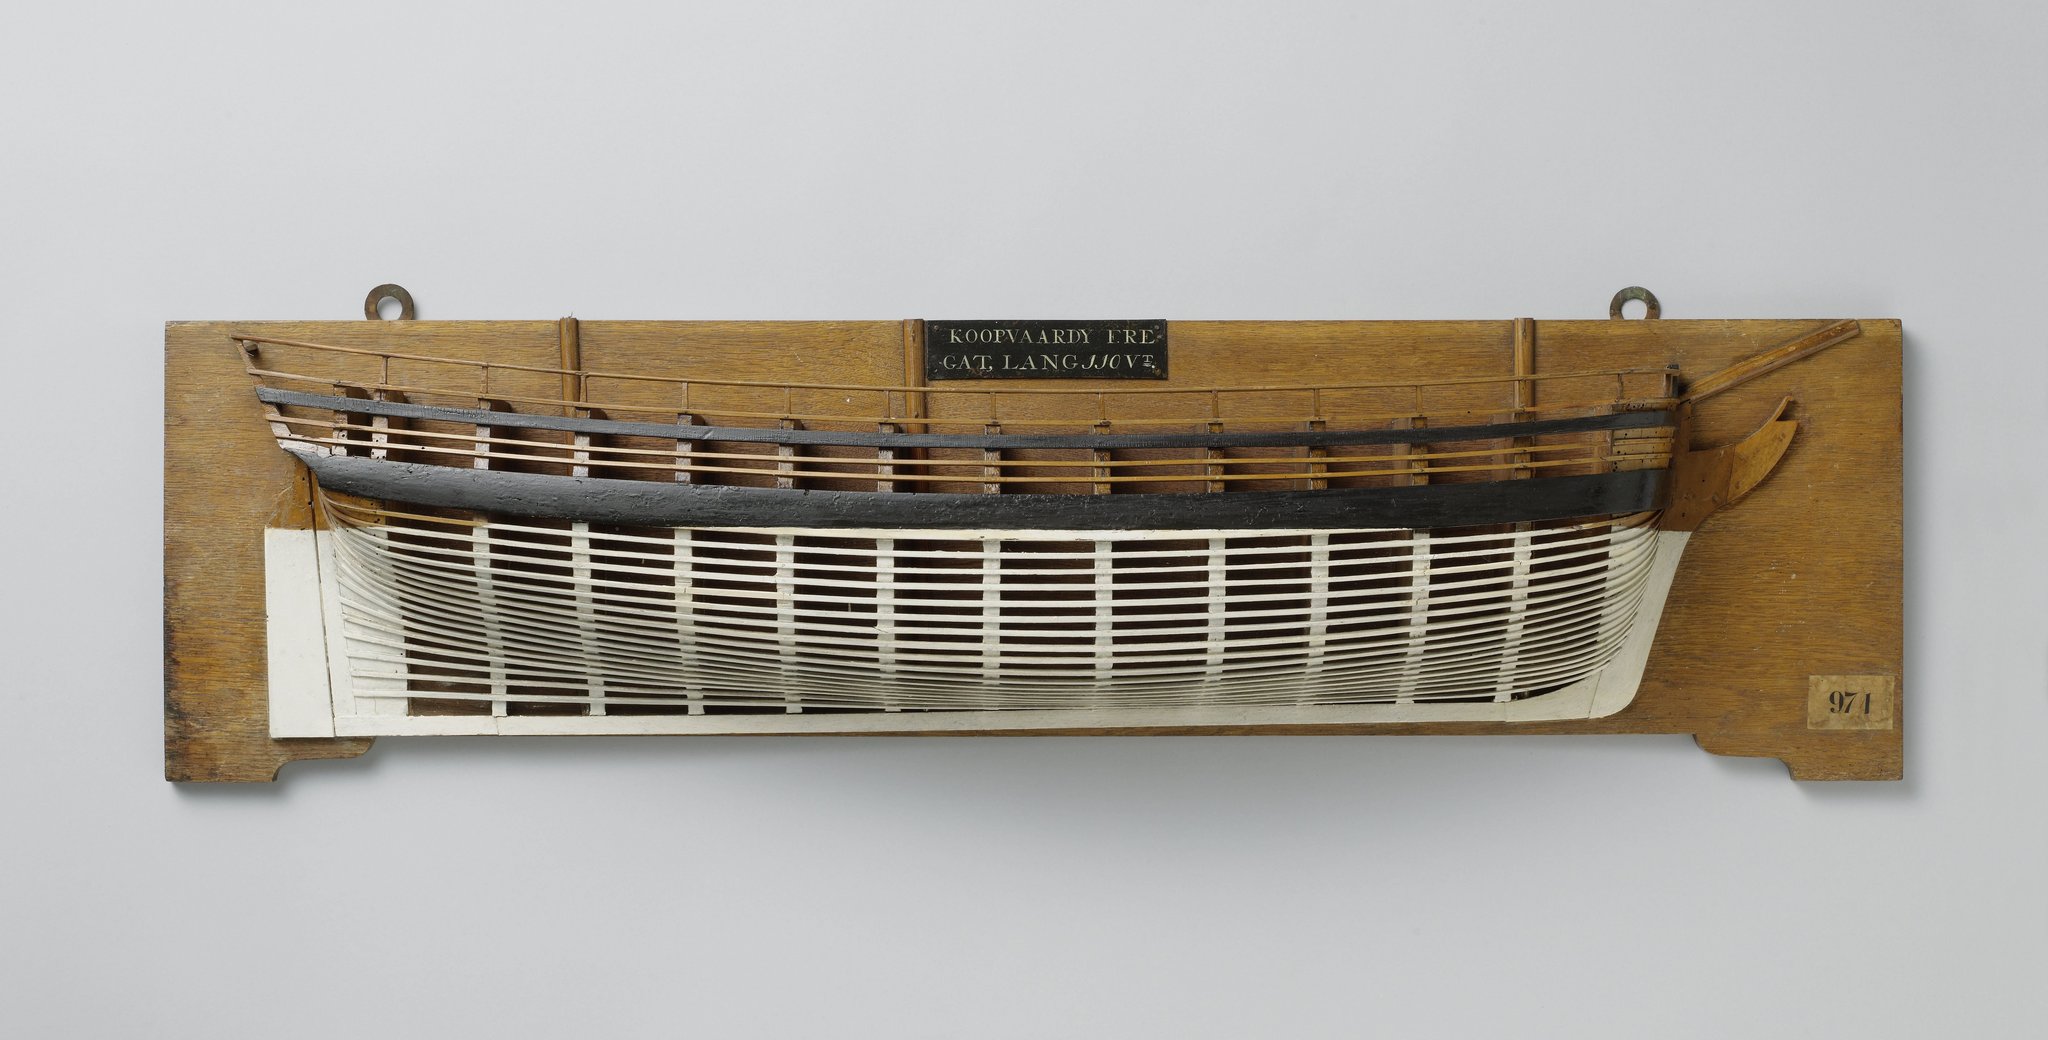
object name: builder's model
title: Half Model of a Merchantman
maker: Anonymous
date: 1780-1820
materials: wood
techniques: polychromy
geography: netherlands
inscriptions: inscription, top centre, on a rectangular black label: ‘KOOPVAARDIJFRE- / GAT, LANG 110 Vt.’, label, bottom right: ‘971’ former inventory label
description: Gepolychromeerd mallenmodel (stuurboord) van een driemaster. Geen dekken of geschutpoorten aangegeven. Het model heeft een reling. Gewrongen spiegel, hol wulf, geen details van hek of zijgalerij; recht roer met vierkante roerkoning. Zeeg naar voren en naar achter oplopend, één barkhout en één reehout. Gepiekt rondspant. Schaal ca. 1:40 (afgeleid).